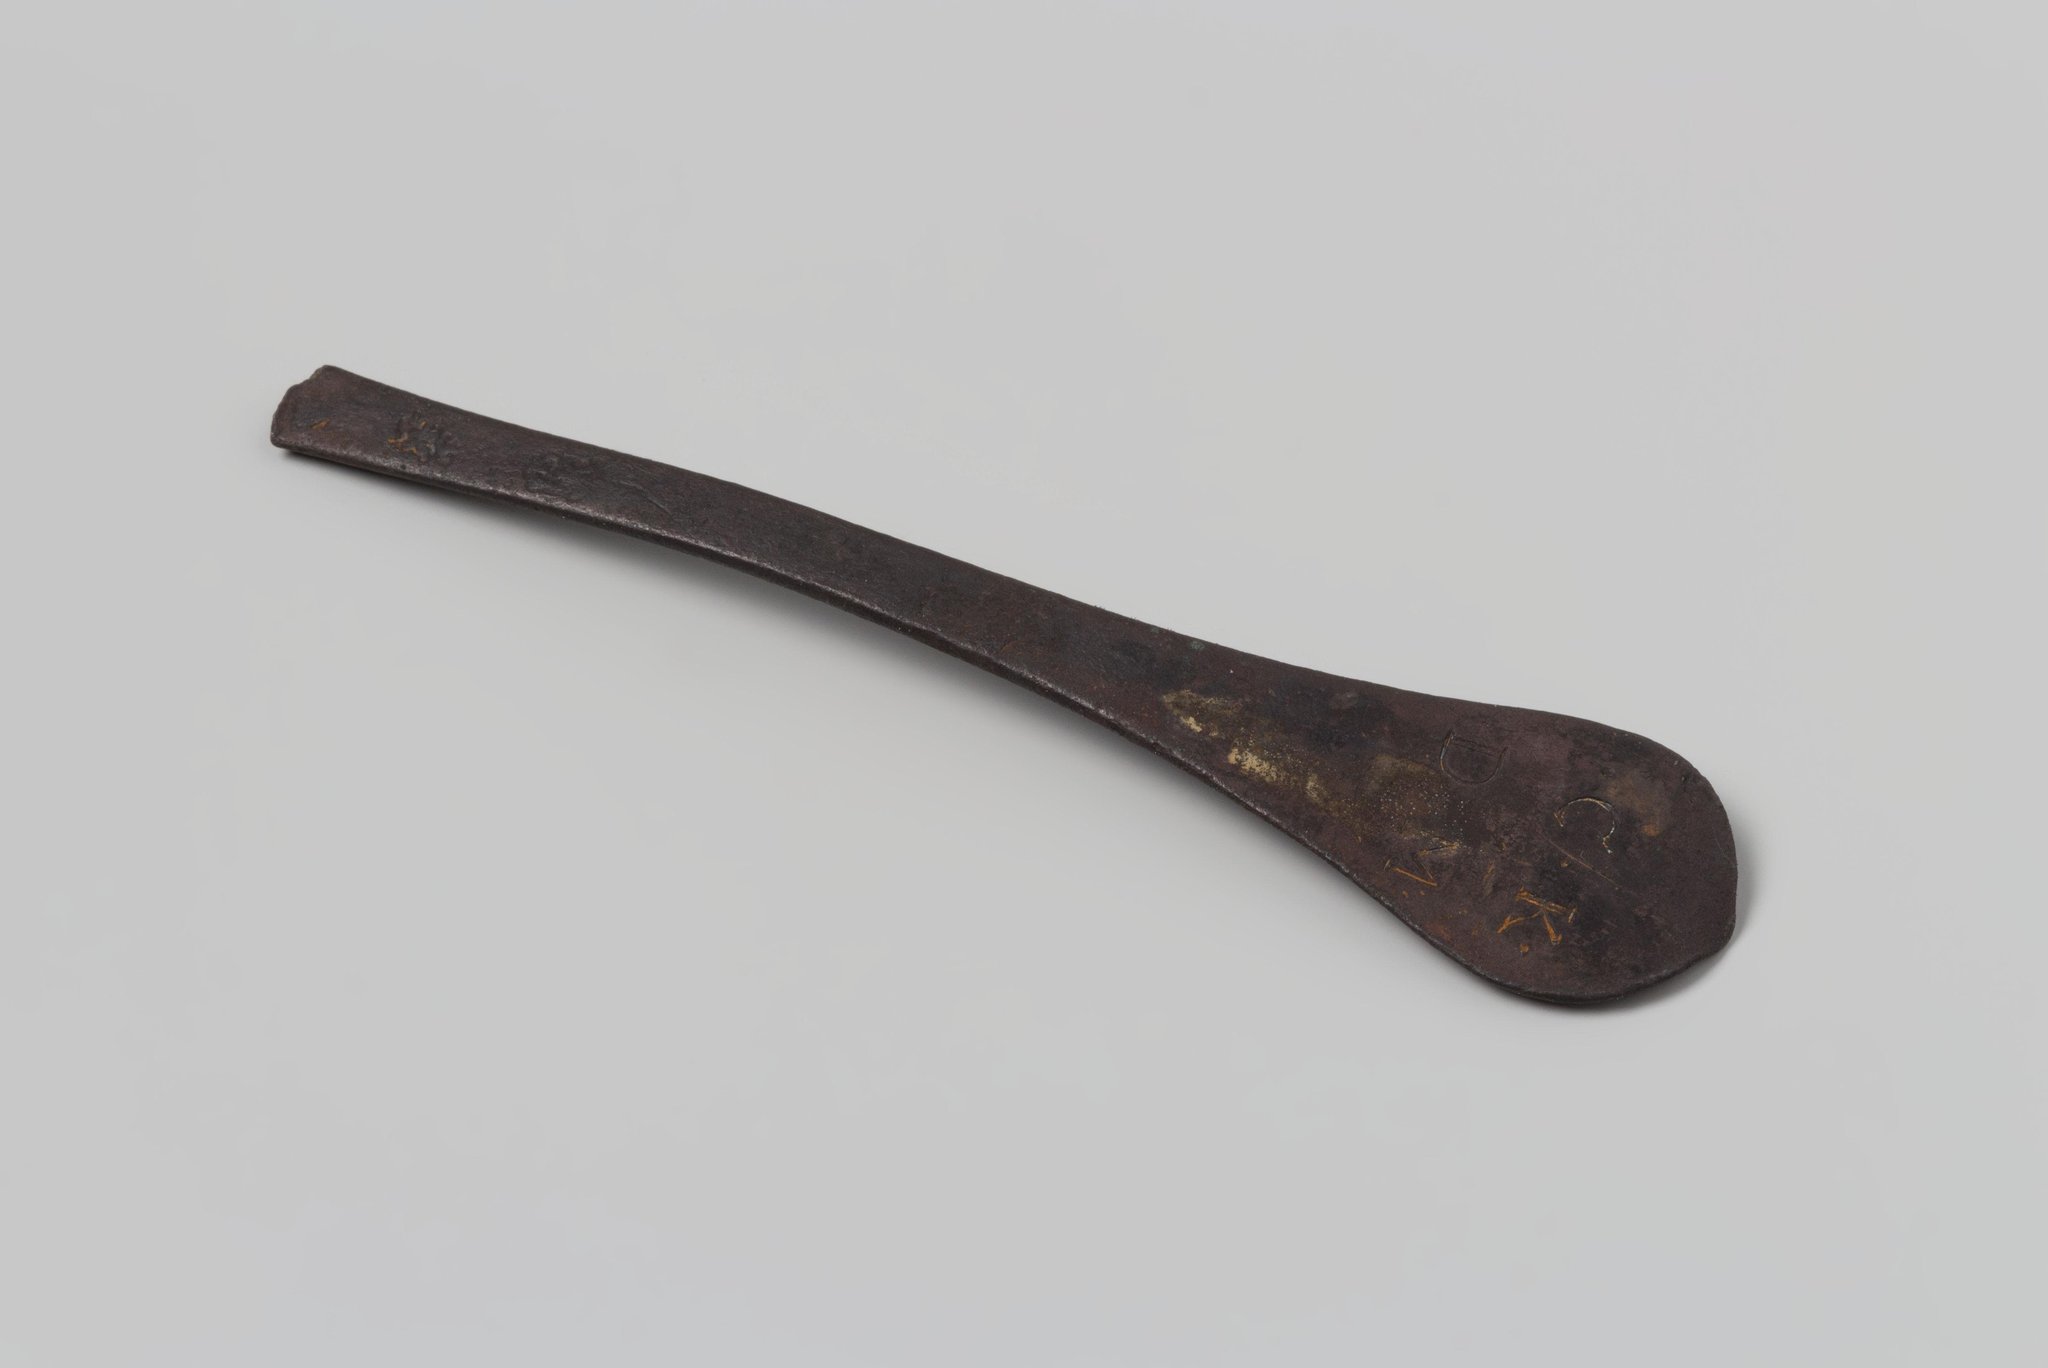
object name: spoon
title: Steel van vork of lepel uit het wrak van de Oost-Indiëvaarder Hollandia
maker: Anonymous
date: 1700-1743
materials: tin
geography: netherlands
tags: verenigde oostindische compagnie, hollandia (schip), annet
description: Cutlery, fragment: stem of fork or spoon; flat, widening towards wavy end, on underside inscription at upper end [C.K.D.M.], 2 marks [HK,(?)K].